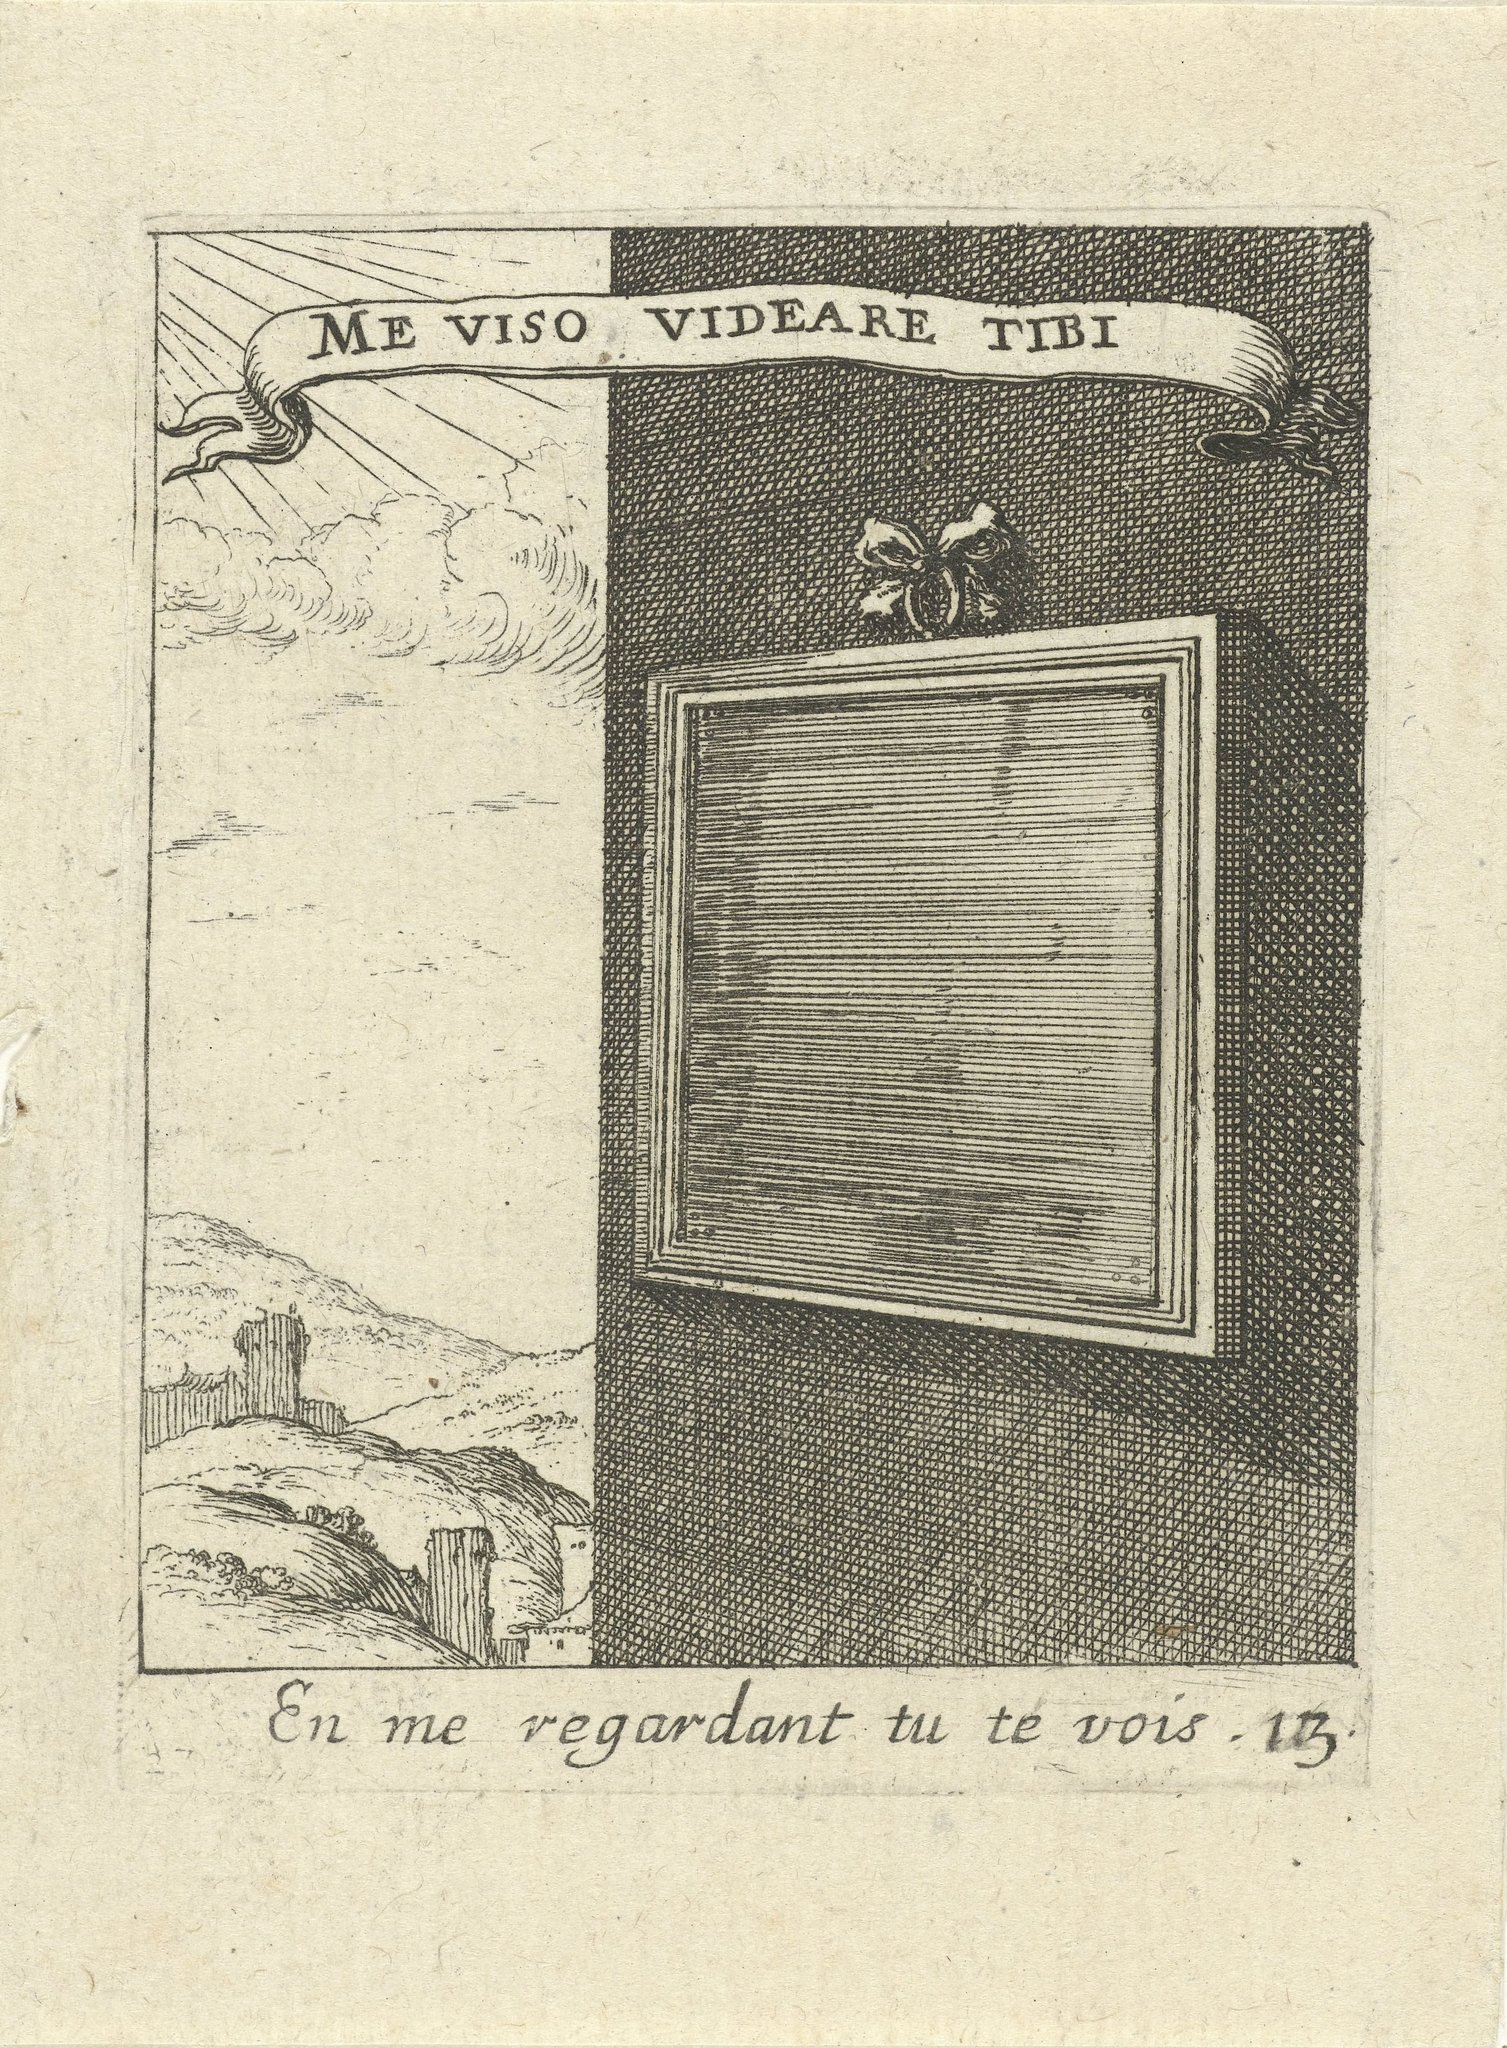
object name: print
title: Moraliserende liefdesemblemen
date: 1672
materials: paper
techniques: etching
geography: paris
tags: qualities of love: first series (+ emblematical representation of concept)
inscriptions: collector's mark: Lugt 2166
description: Een spiegel op een donkere muur. Op de achtergrond een berglandschap. Op een banderol een devies in Latijn en een onderschrift in Frans, beide over de liefde.